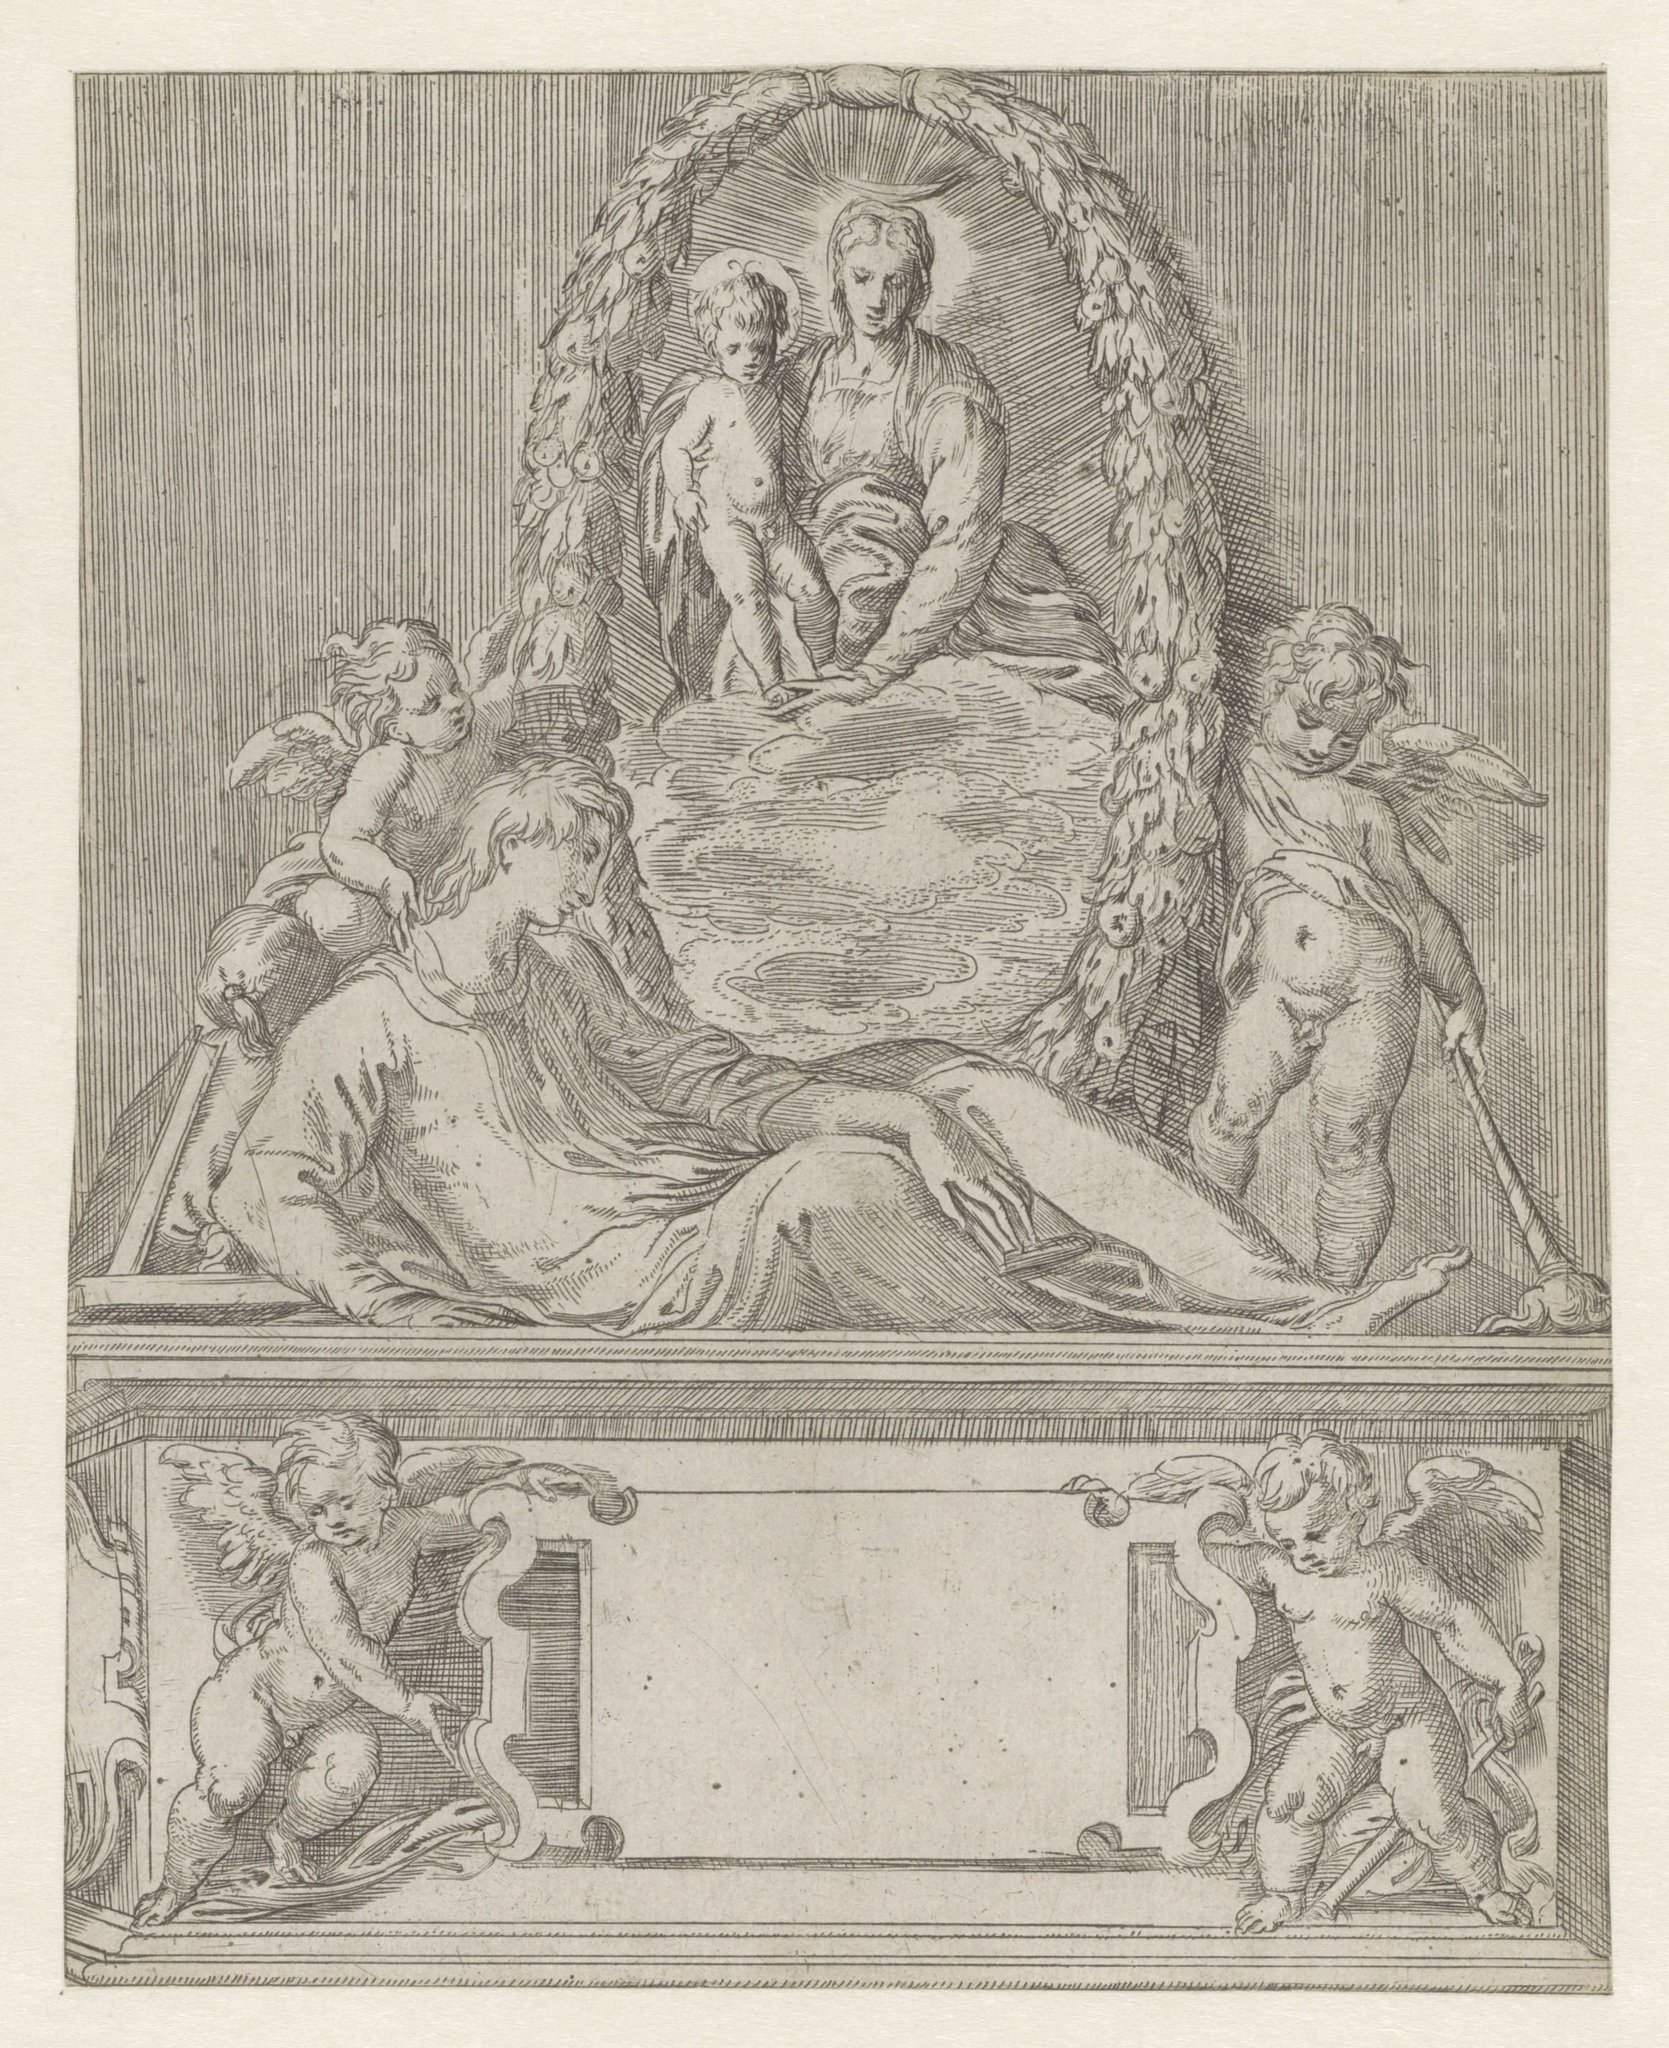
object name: print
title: Graftombe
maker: angelo falco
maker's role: print maker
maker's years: 1600-1695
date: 1619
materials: paper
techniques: etching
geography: italy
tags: madonna: i.e. mary with the christ-child, grave, tomb, cupids: 'amores', 'amoretti', 'putti'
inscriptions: collector's mark: Lugt 2760, collector's mark: Lugt 2228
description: Een graftombe bestaande uit twee lagen. Onder twee putti naast een leeg cartouche. Bovenop een liggende figuur en een voorstelling van Maria met Kind die aan weerszijden wordt geflankeerd door een putto.